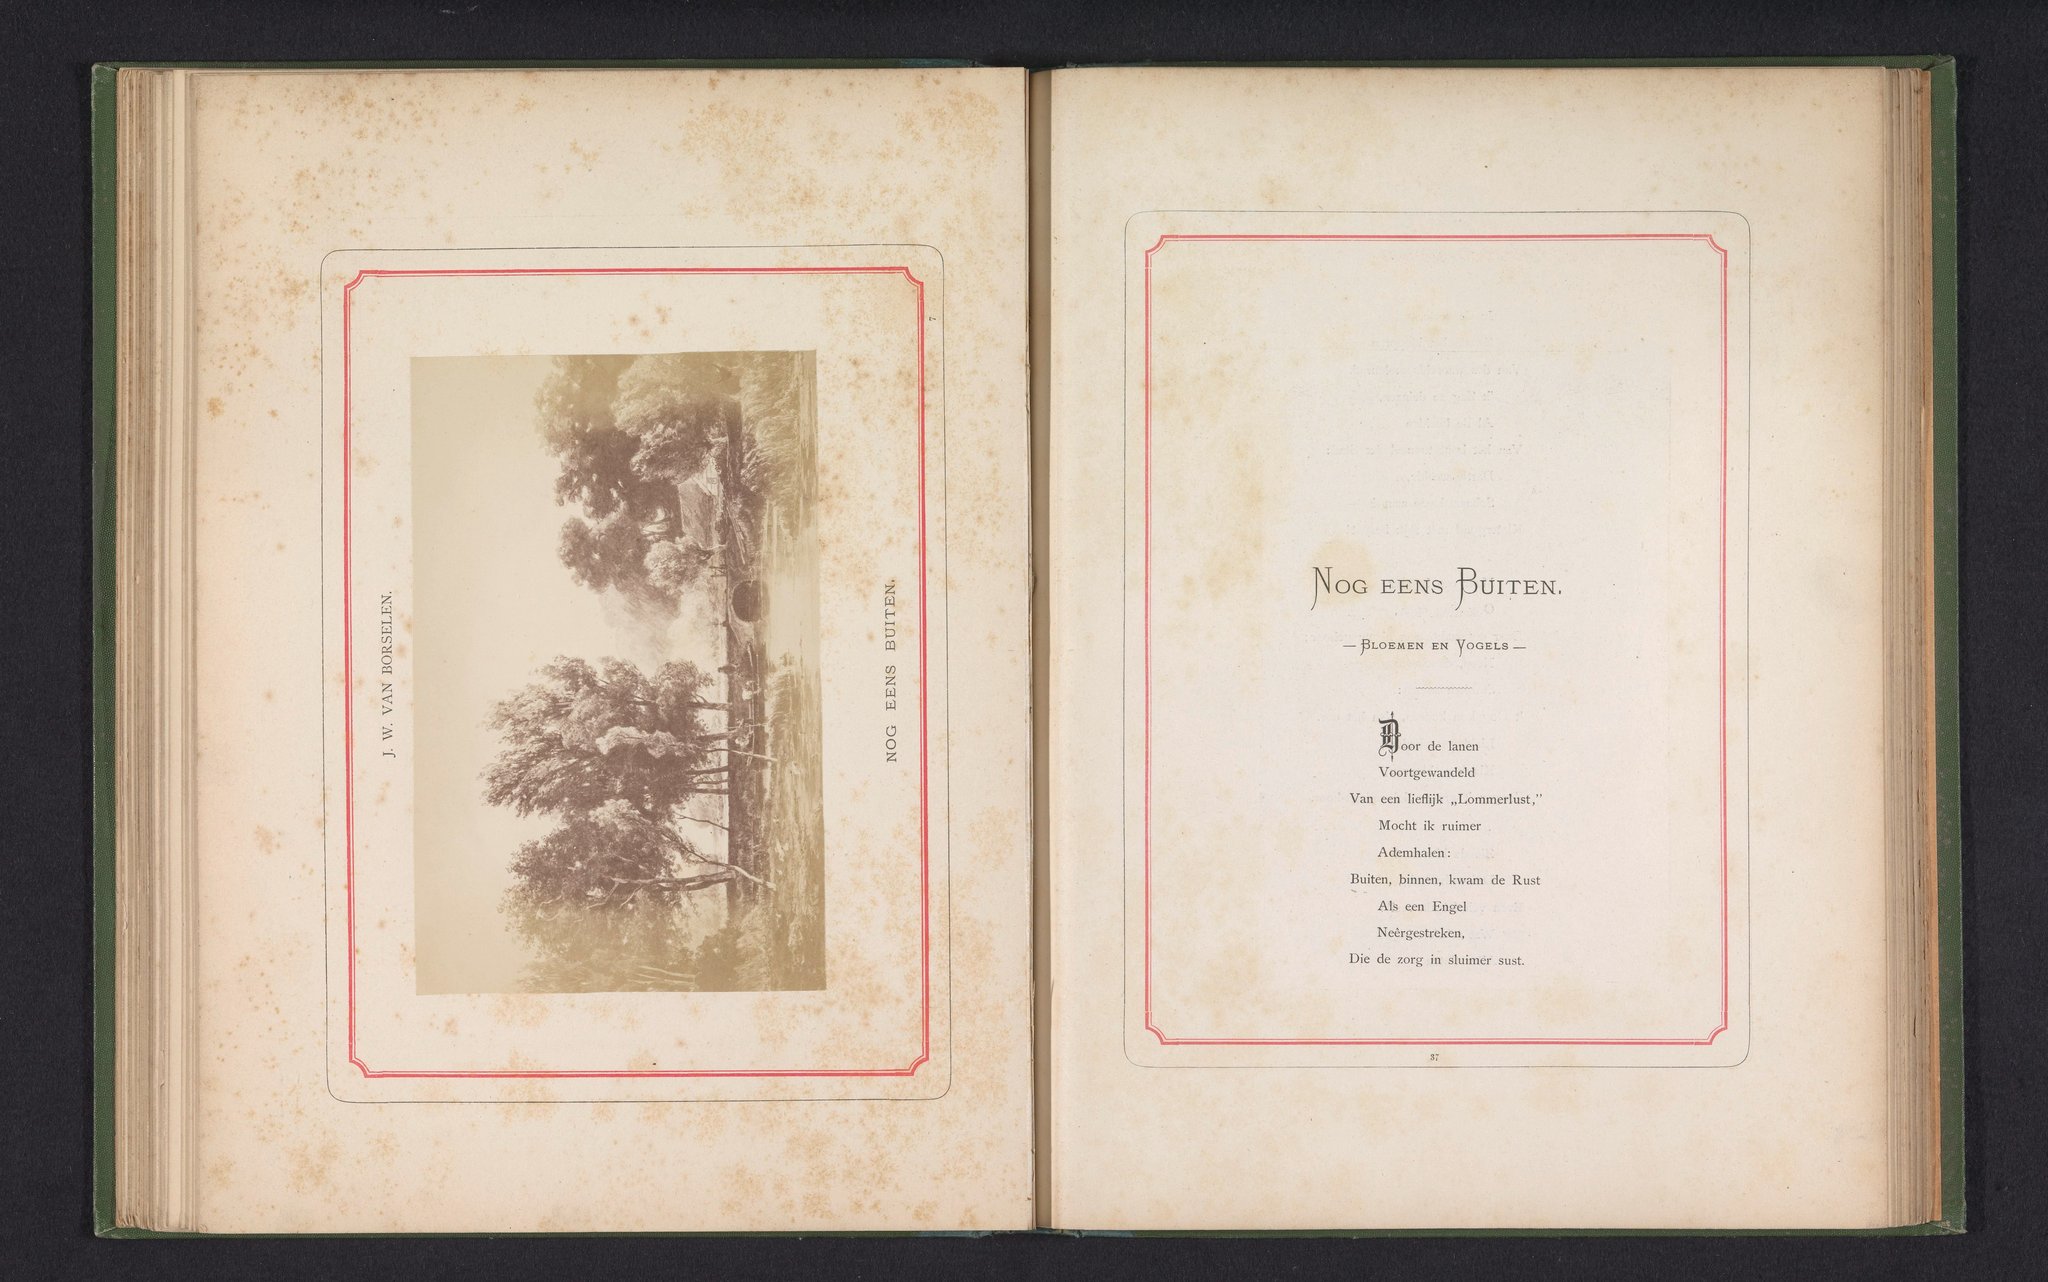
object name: page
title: Nog eens buiten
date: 1868-1878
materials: photographic support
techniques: albumen print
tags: rowing-boat, canoe, etc., lake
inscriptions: number: ‘7’